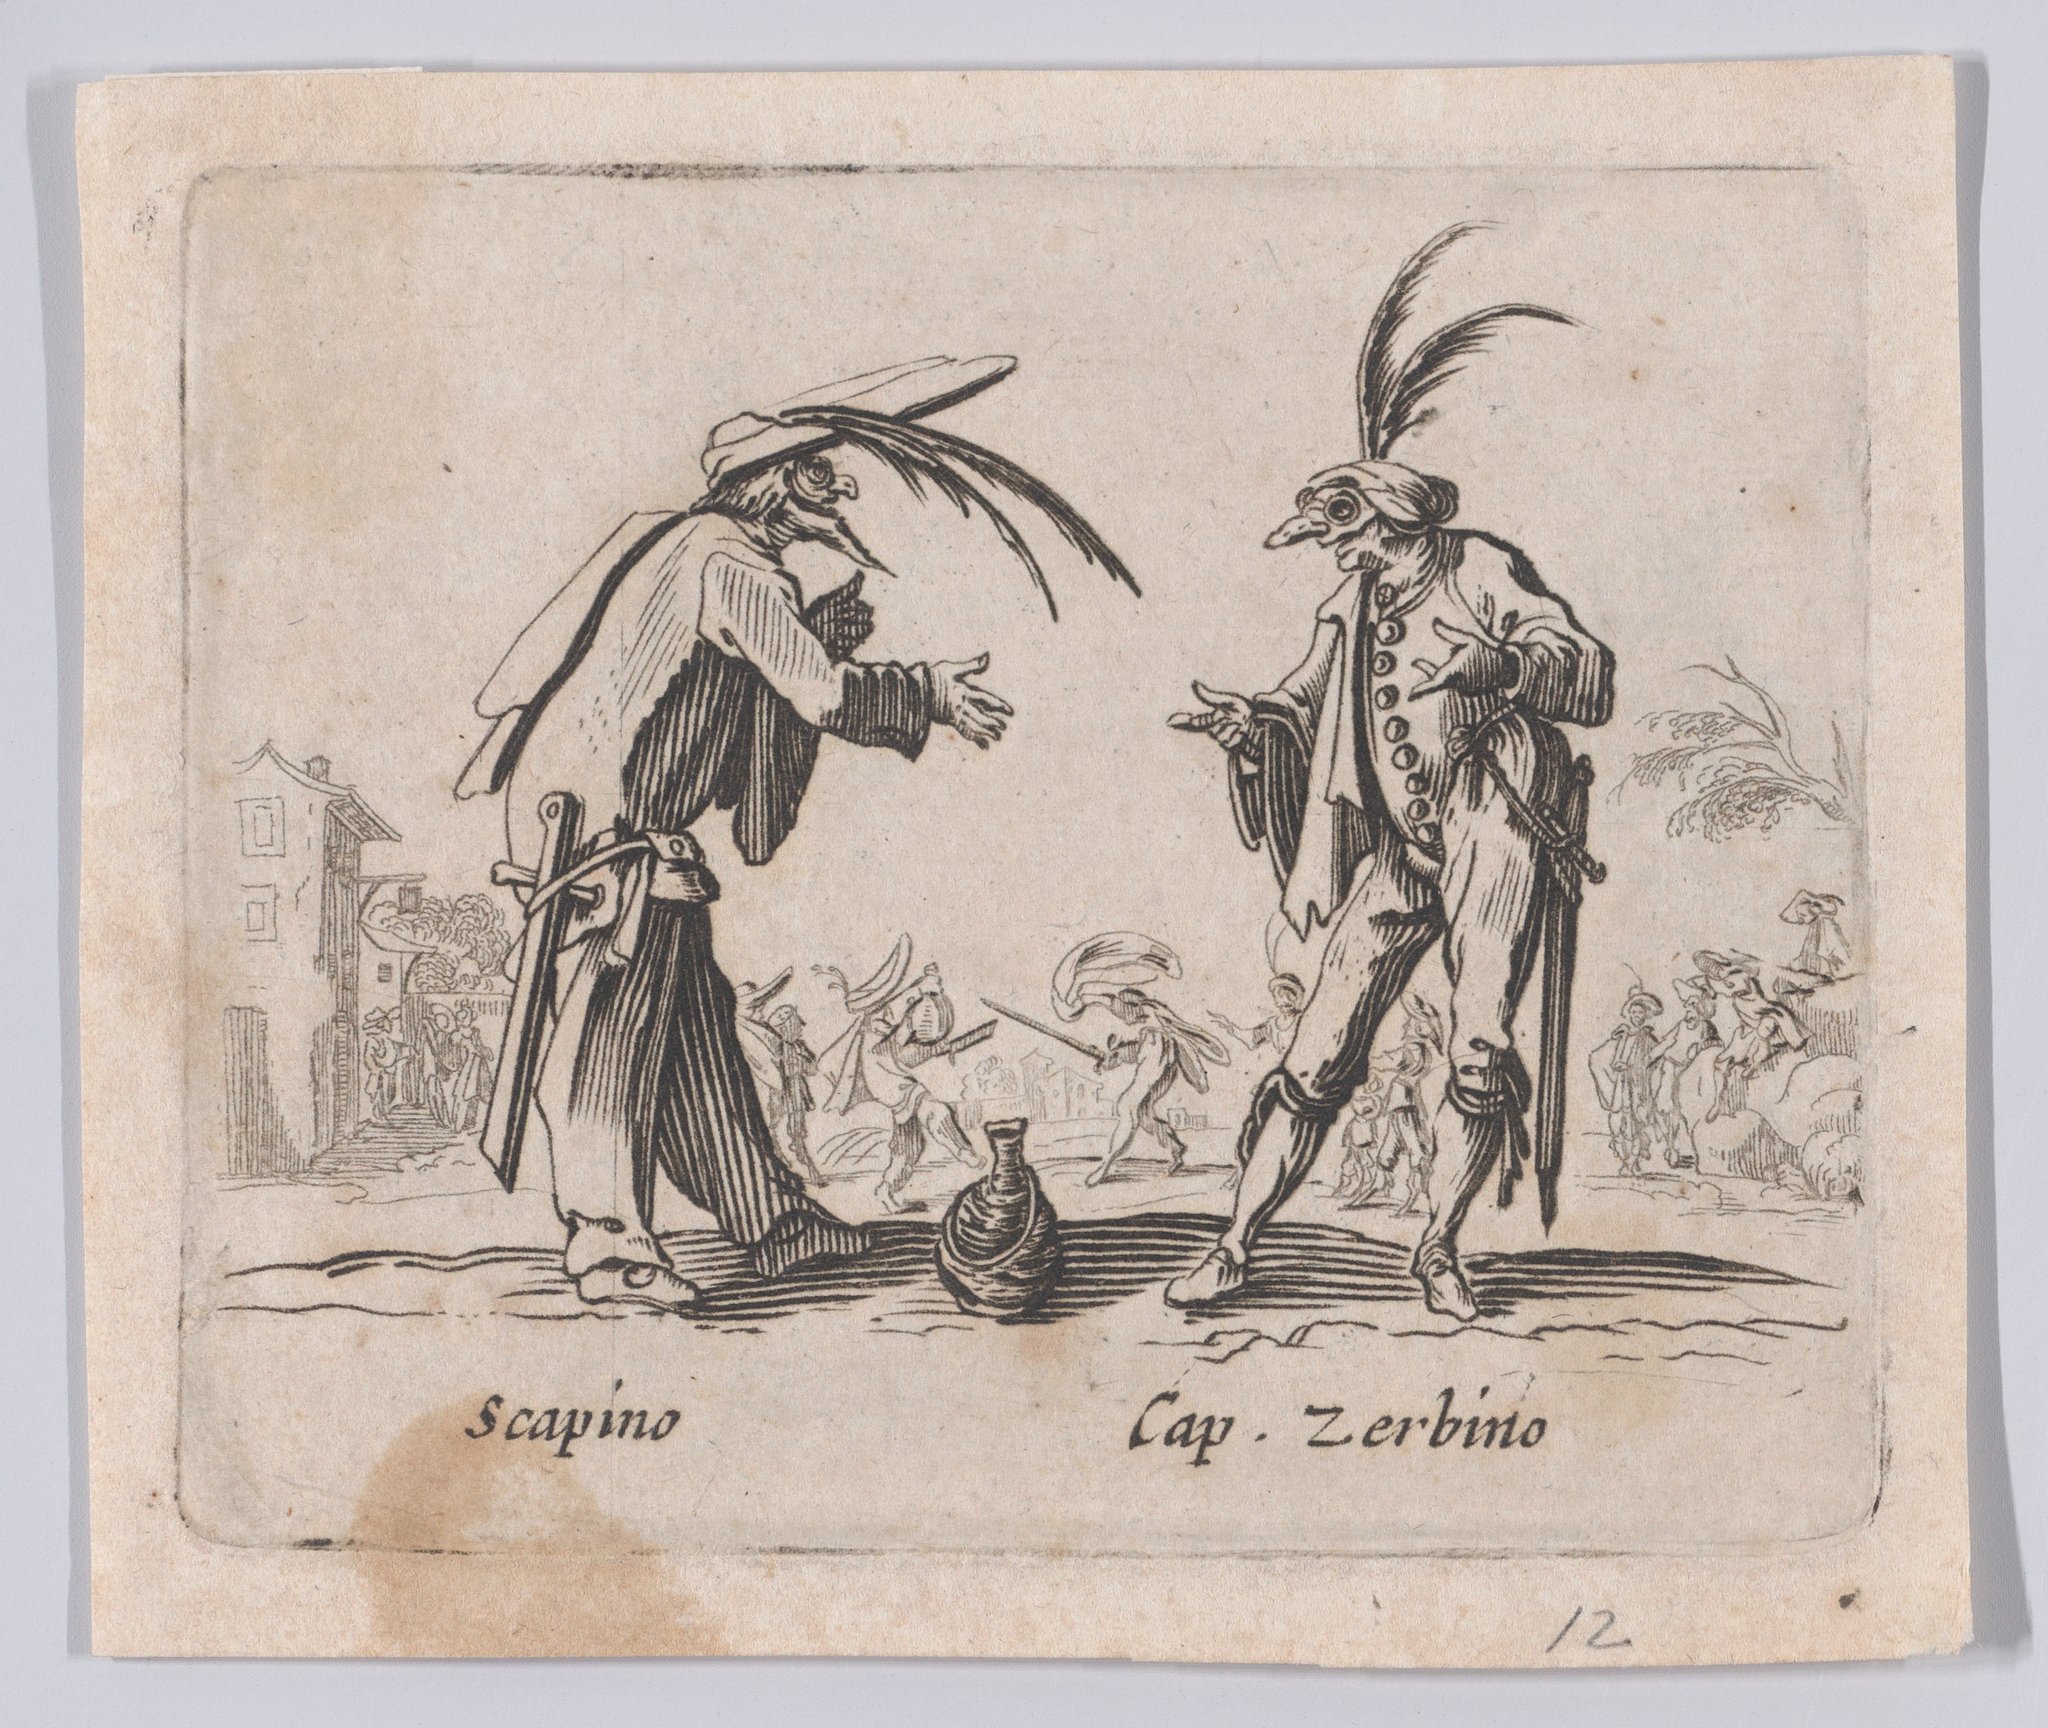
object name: print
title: Copy of Scapino and Capitano Zerbino, from "Balli di Sfessania" (Dance of Sfessania)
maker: jacques callot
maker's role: artist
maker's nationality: french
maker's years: 1592-1635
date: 1622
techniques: etching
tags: men,dancing